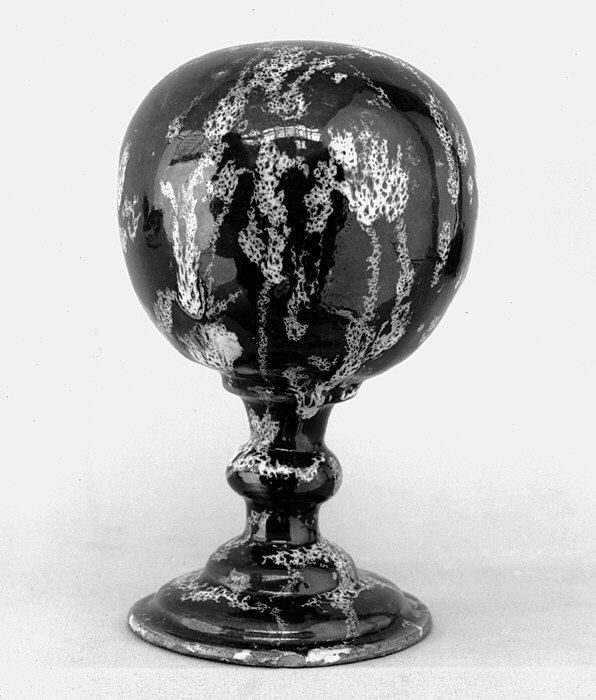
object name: wig rest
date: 1720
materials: faience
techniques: glazing